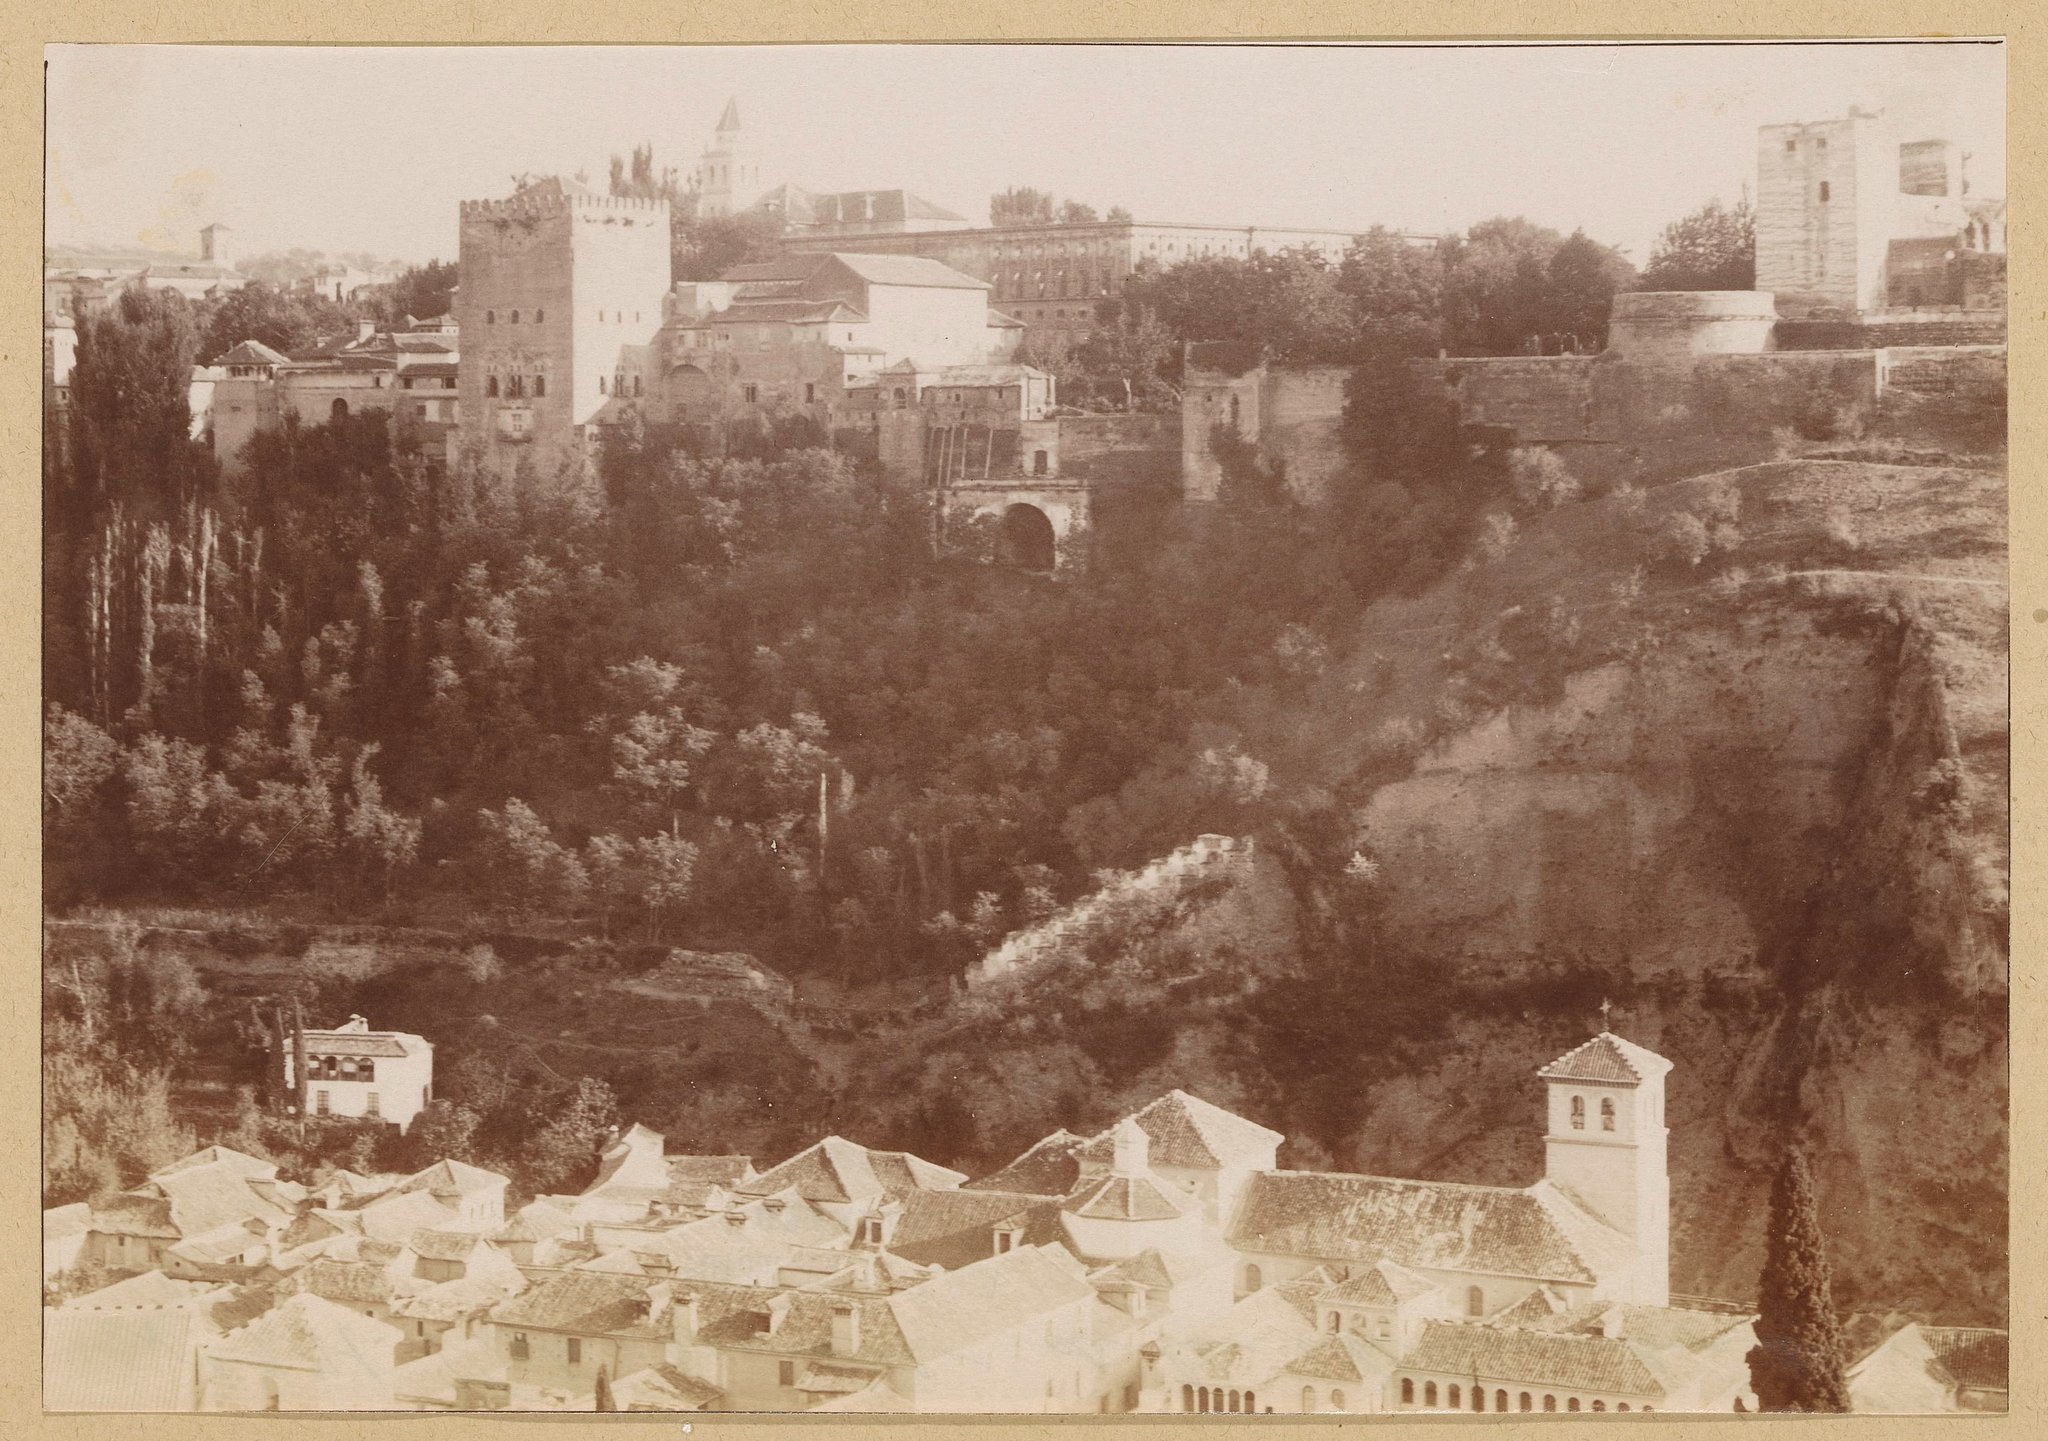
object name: photograph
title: Gezicht op het Alhambra in Granada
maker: Anonymous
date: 1851-1890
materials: paper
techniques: albumen print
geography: granada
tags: fortress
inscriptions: inscription: ‘Granada Alhambra’